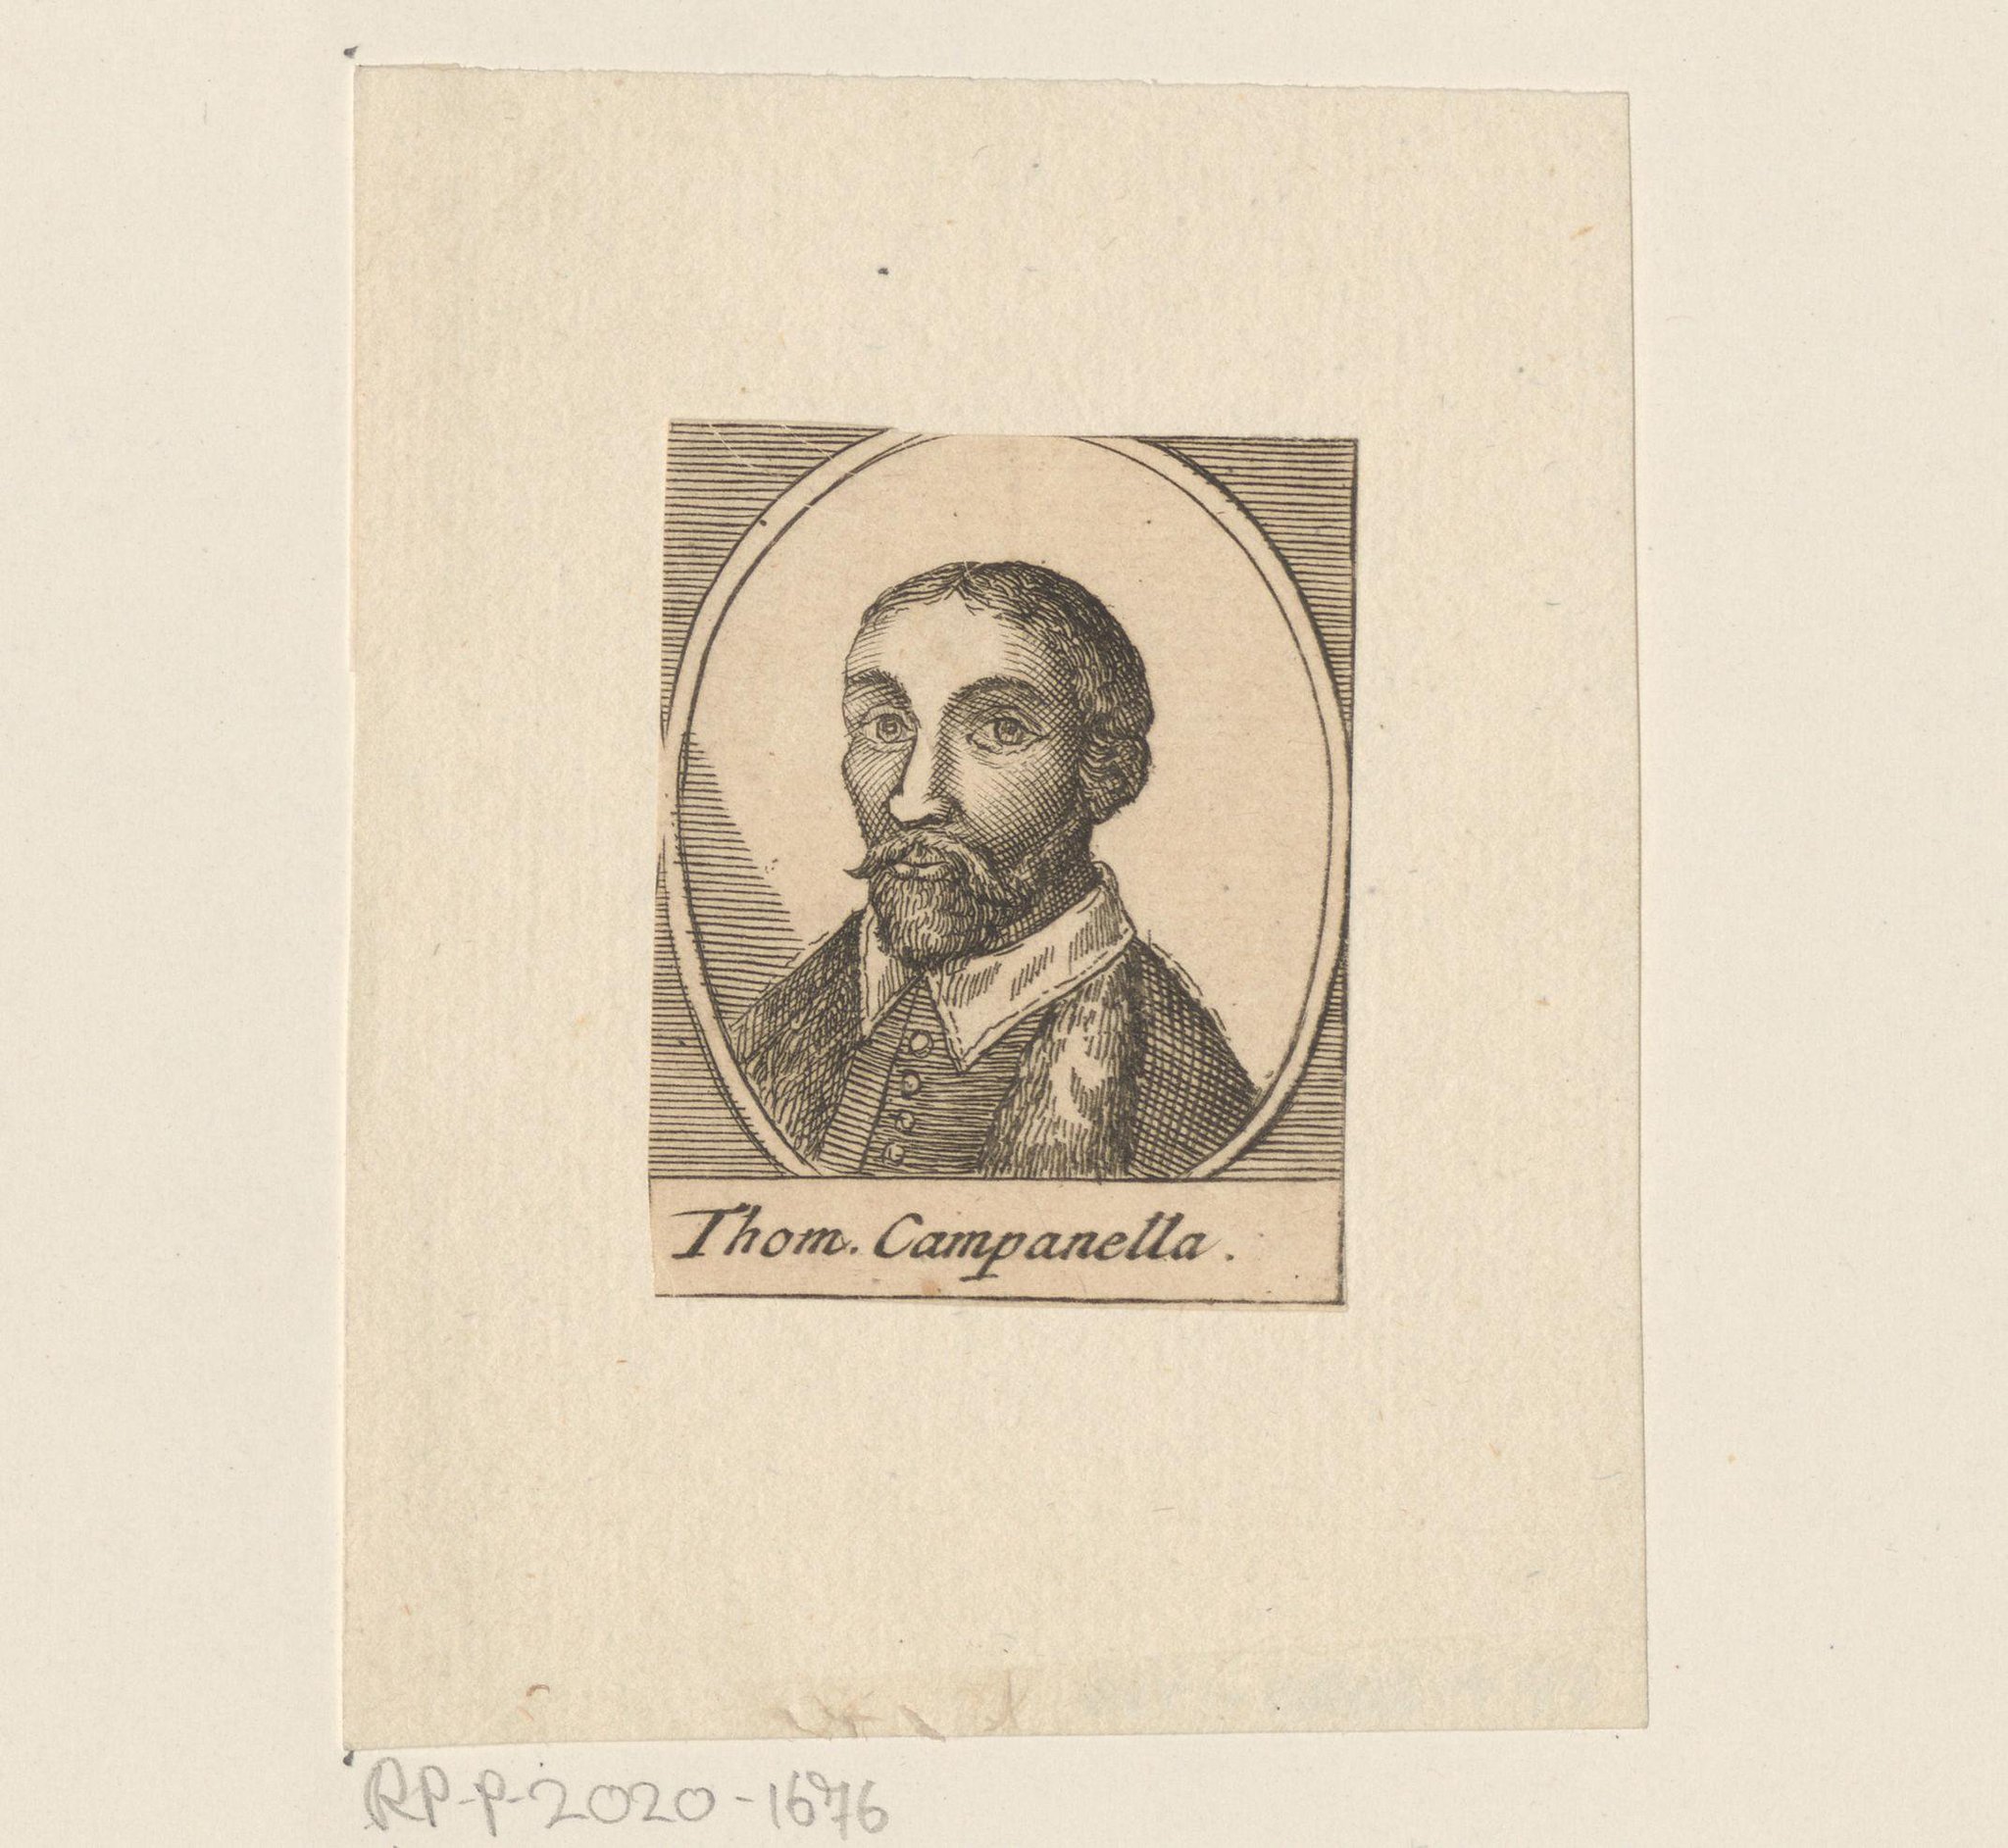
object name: print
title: Portret van Tommaso Campanella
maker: Anonymous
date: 1650-1749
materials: paper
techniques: engraving, etching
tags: historical persons